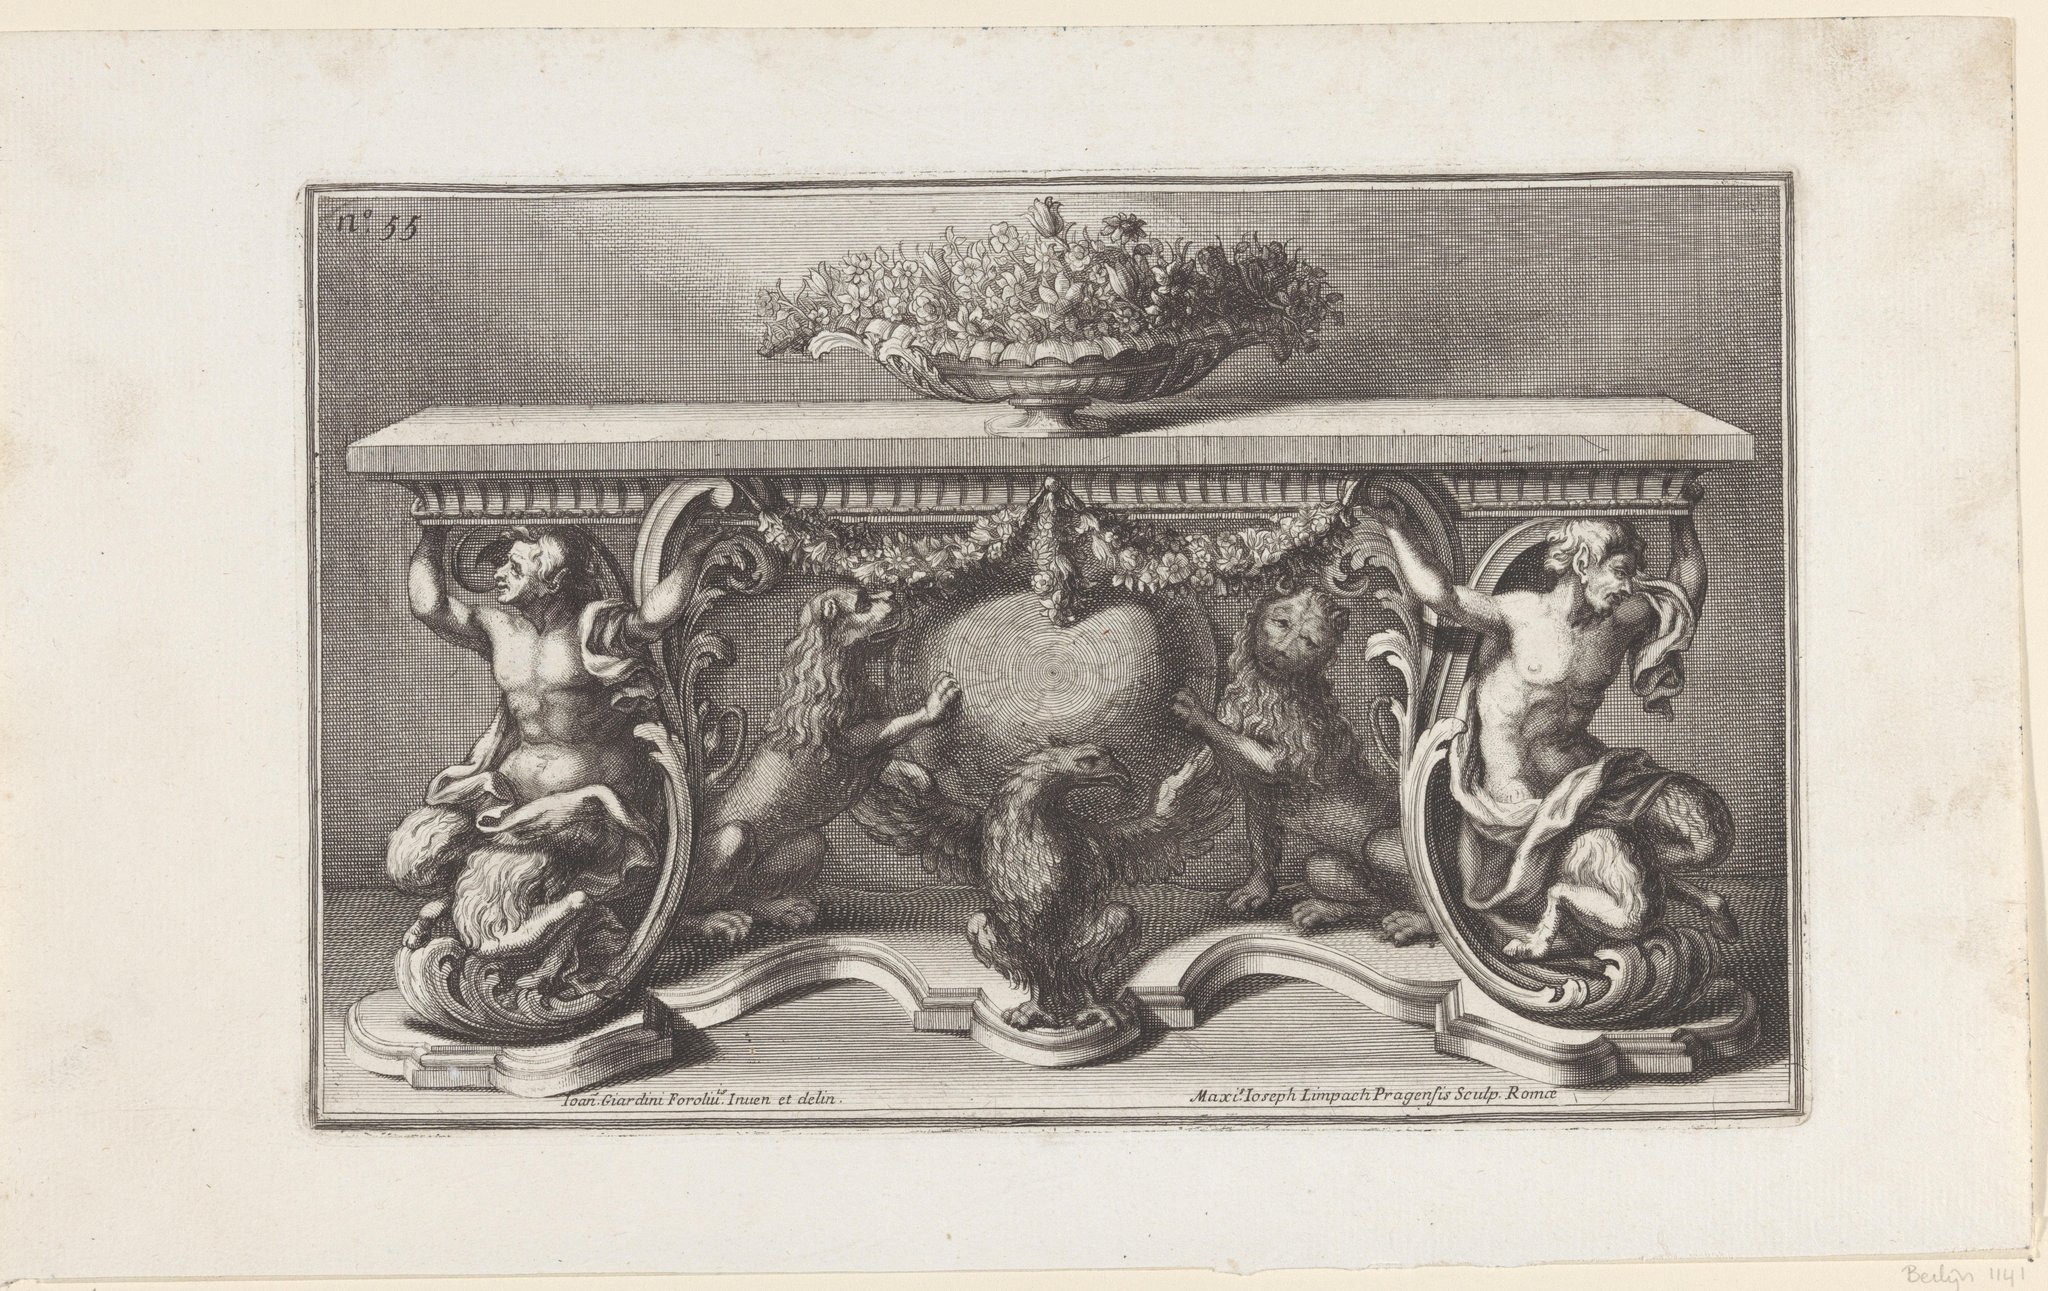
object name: ornament print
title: Diverse kerkelijke voorwerpen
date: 1714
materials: paper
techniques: etching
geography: italy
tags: ornaments ~ art, predatory birds: eagle, table, satyr(s) (in general), beasts of prey, predatory animals: lion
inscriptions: collector's mark: Lugt 2228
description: Tafel met ornamentele poten met twee leeuwen, een adelaar en saters. Op de tafel staat een schaal met bloemen. Genummerd linksboven: no. 55.